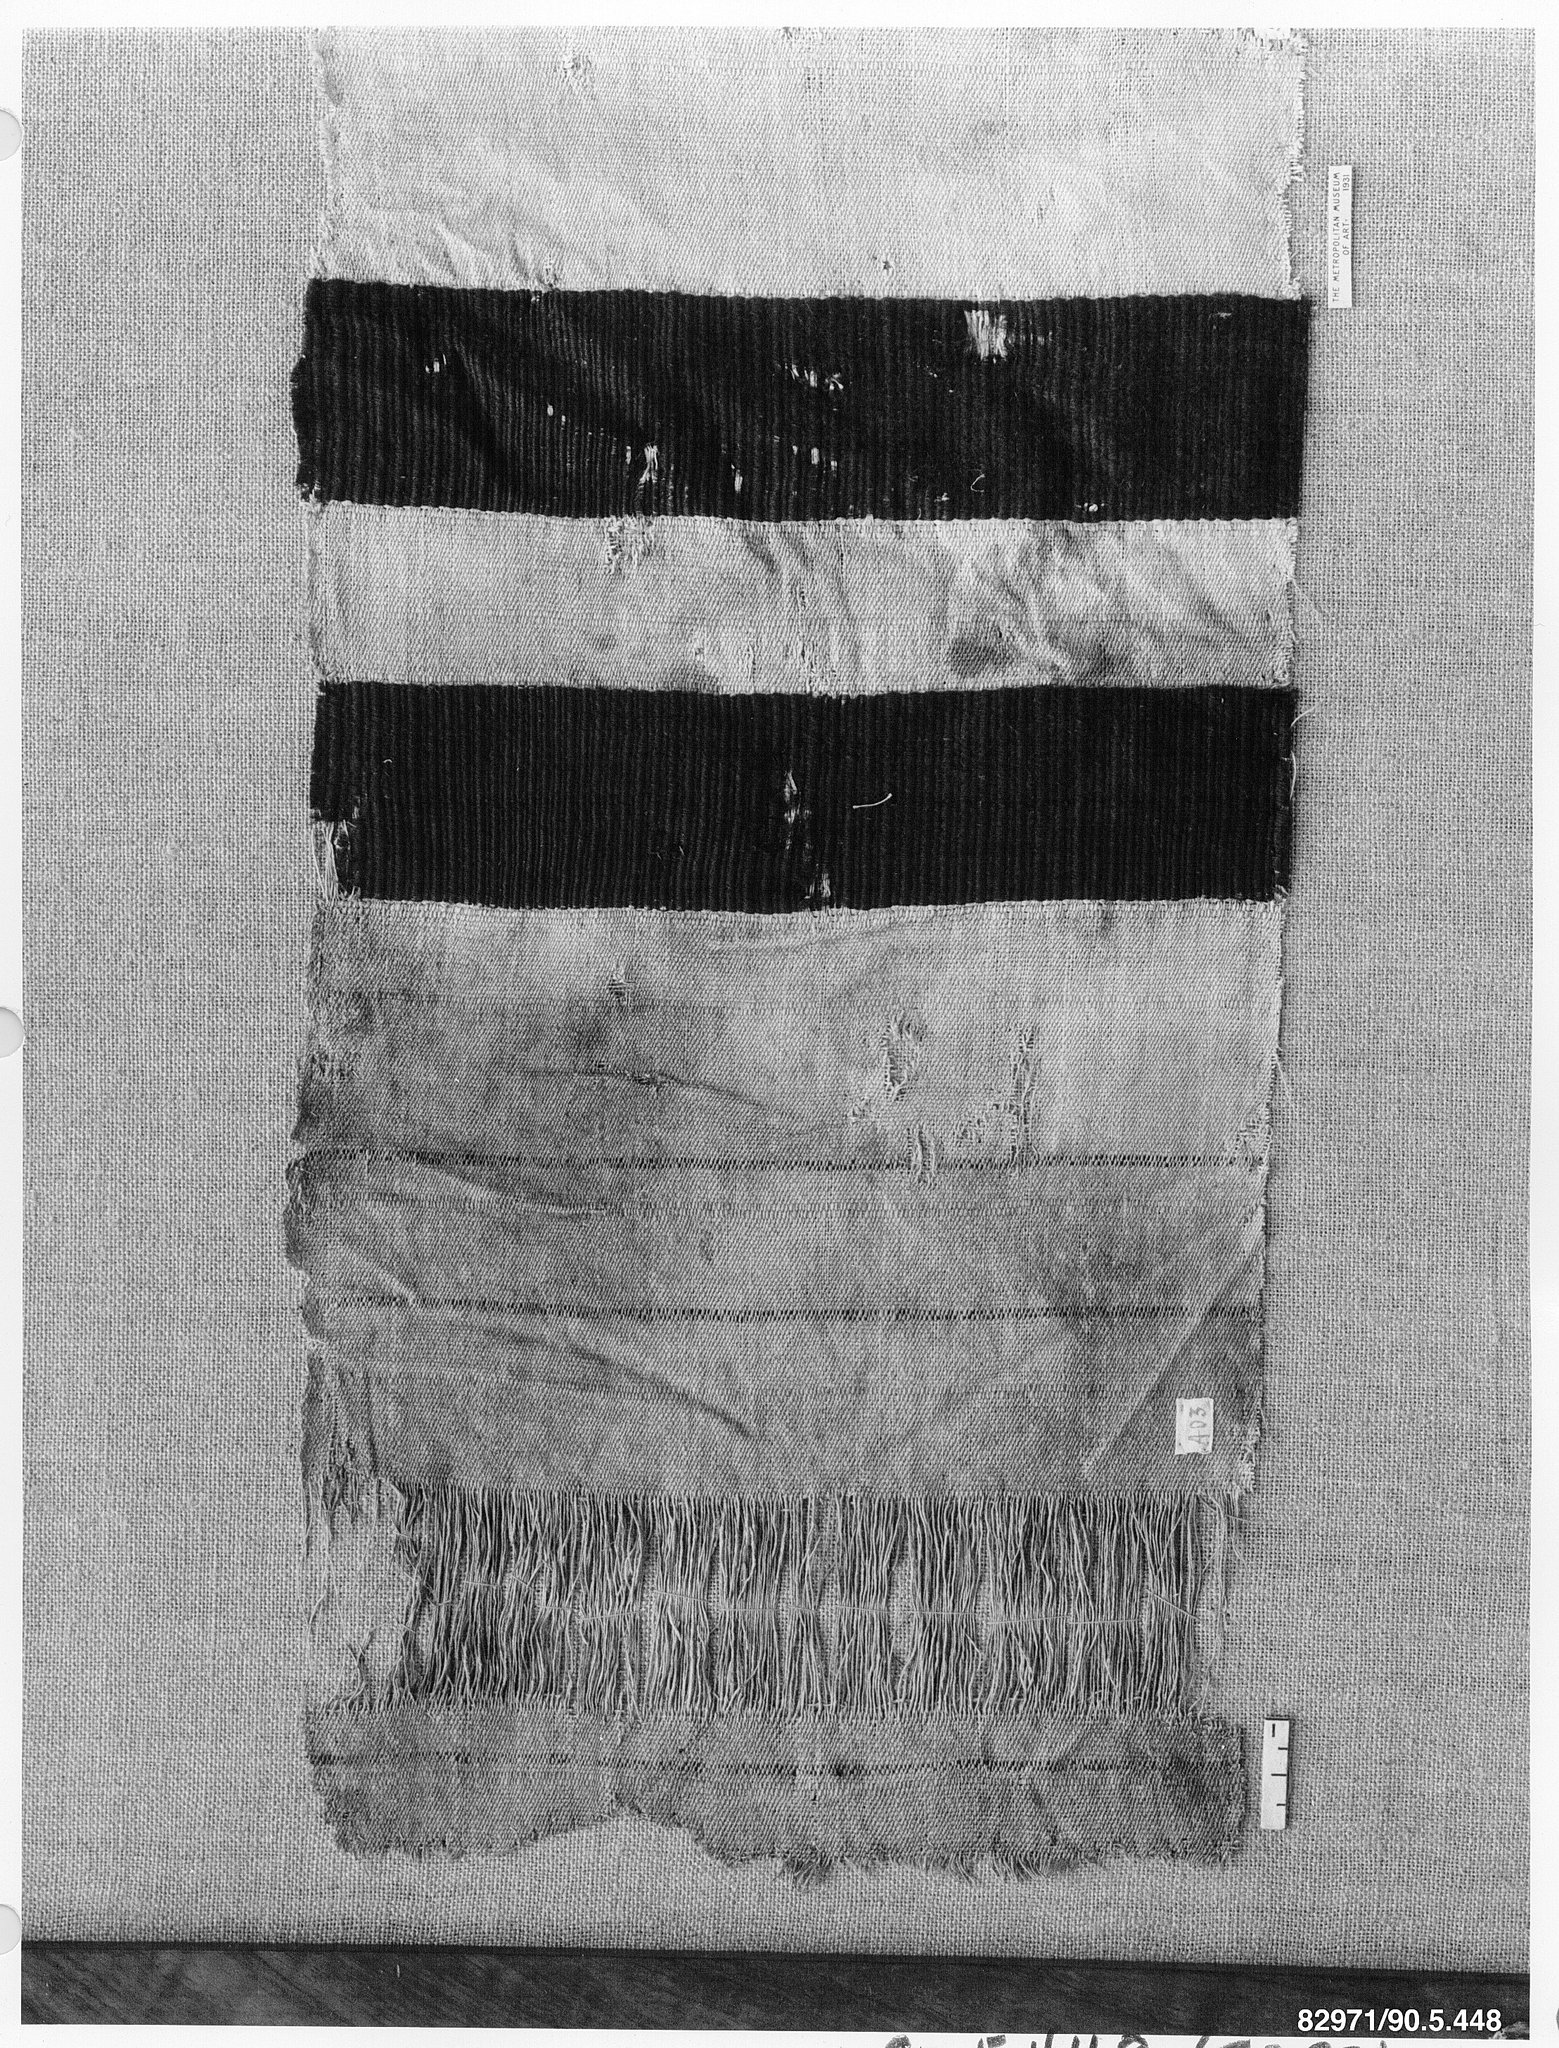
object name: textile fragment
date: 101-300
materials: linen, wool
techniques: weave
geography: egypt